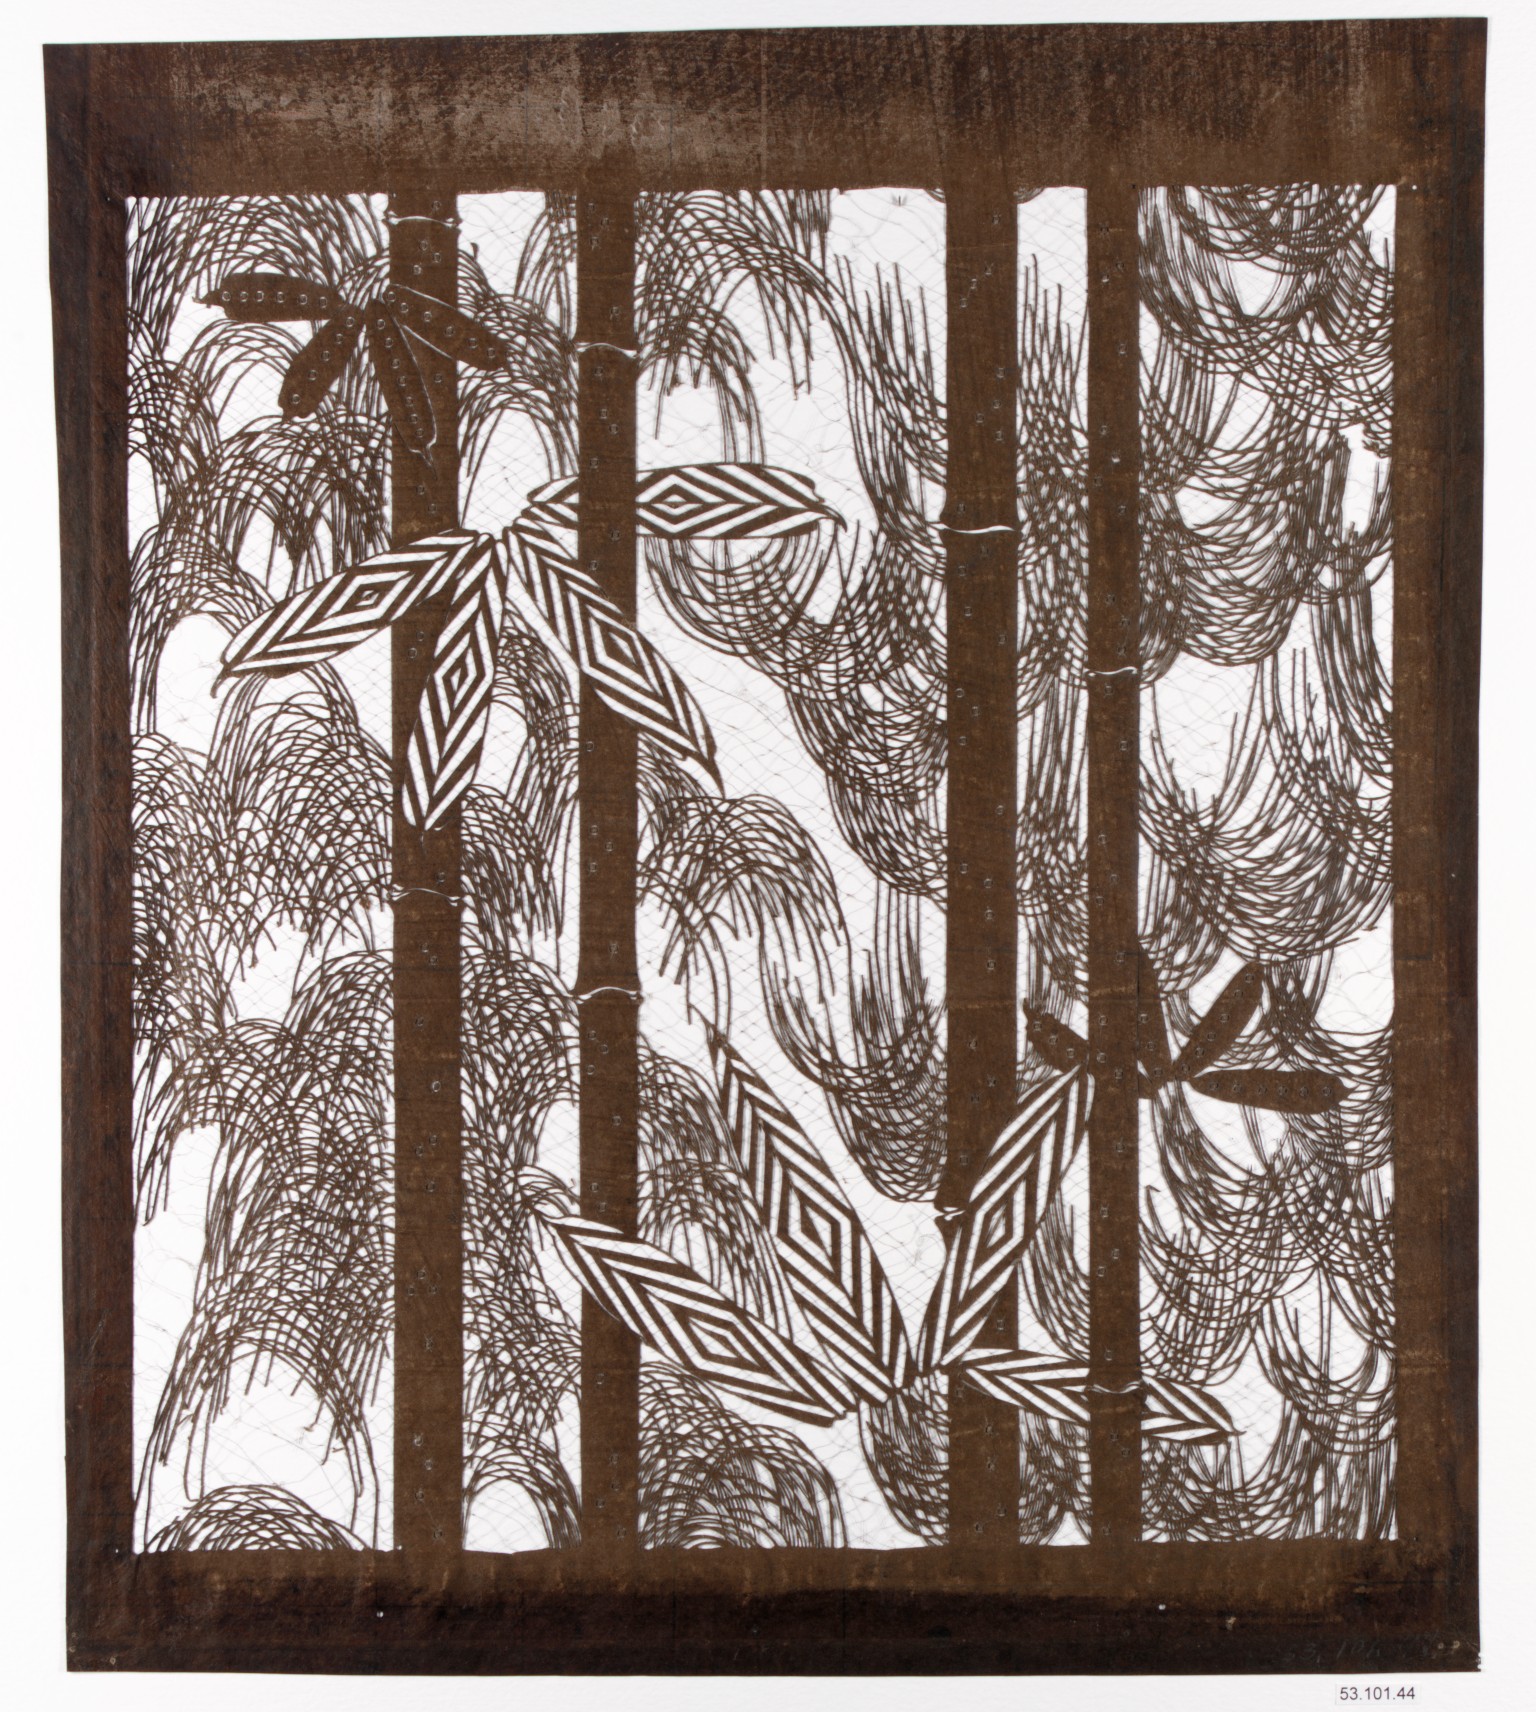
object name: stencil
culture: japanese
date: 1615-1868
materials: paper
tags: bamboo